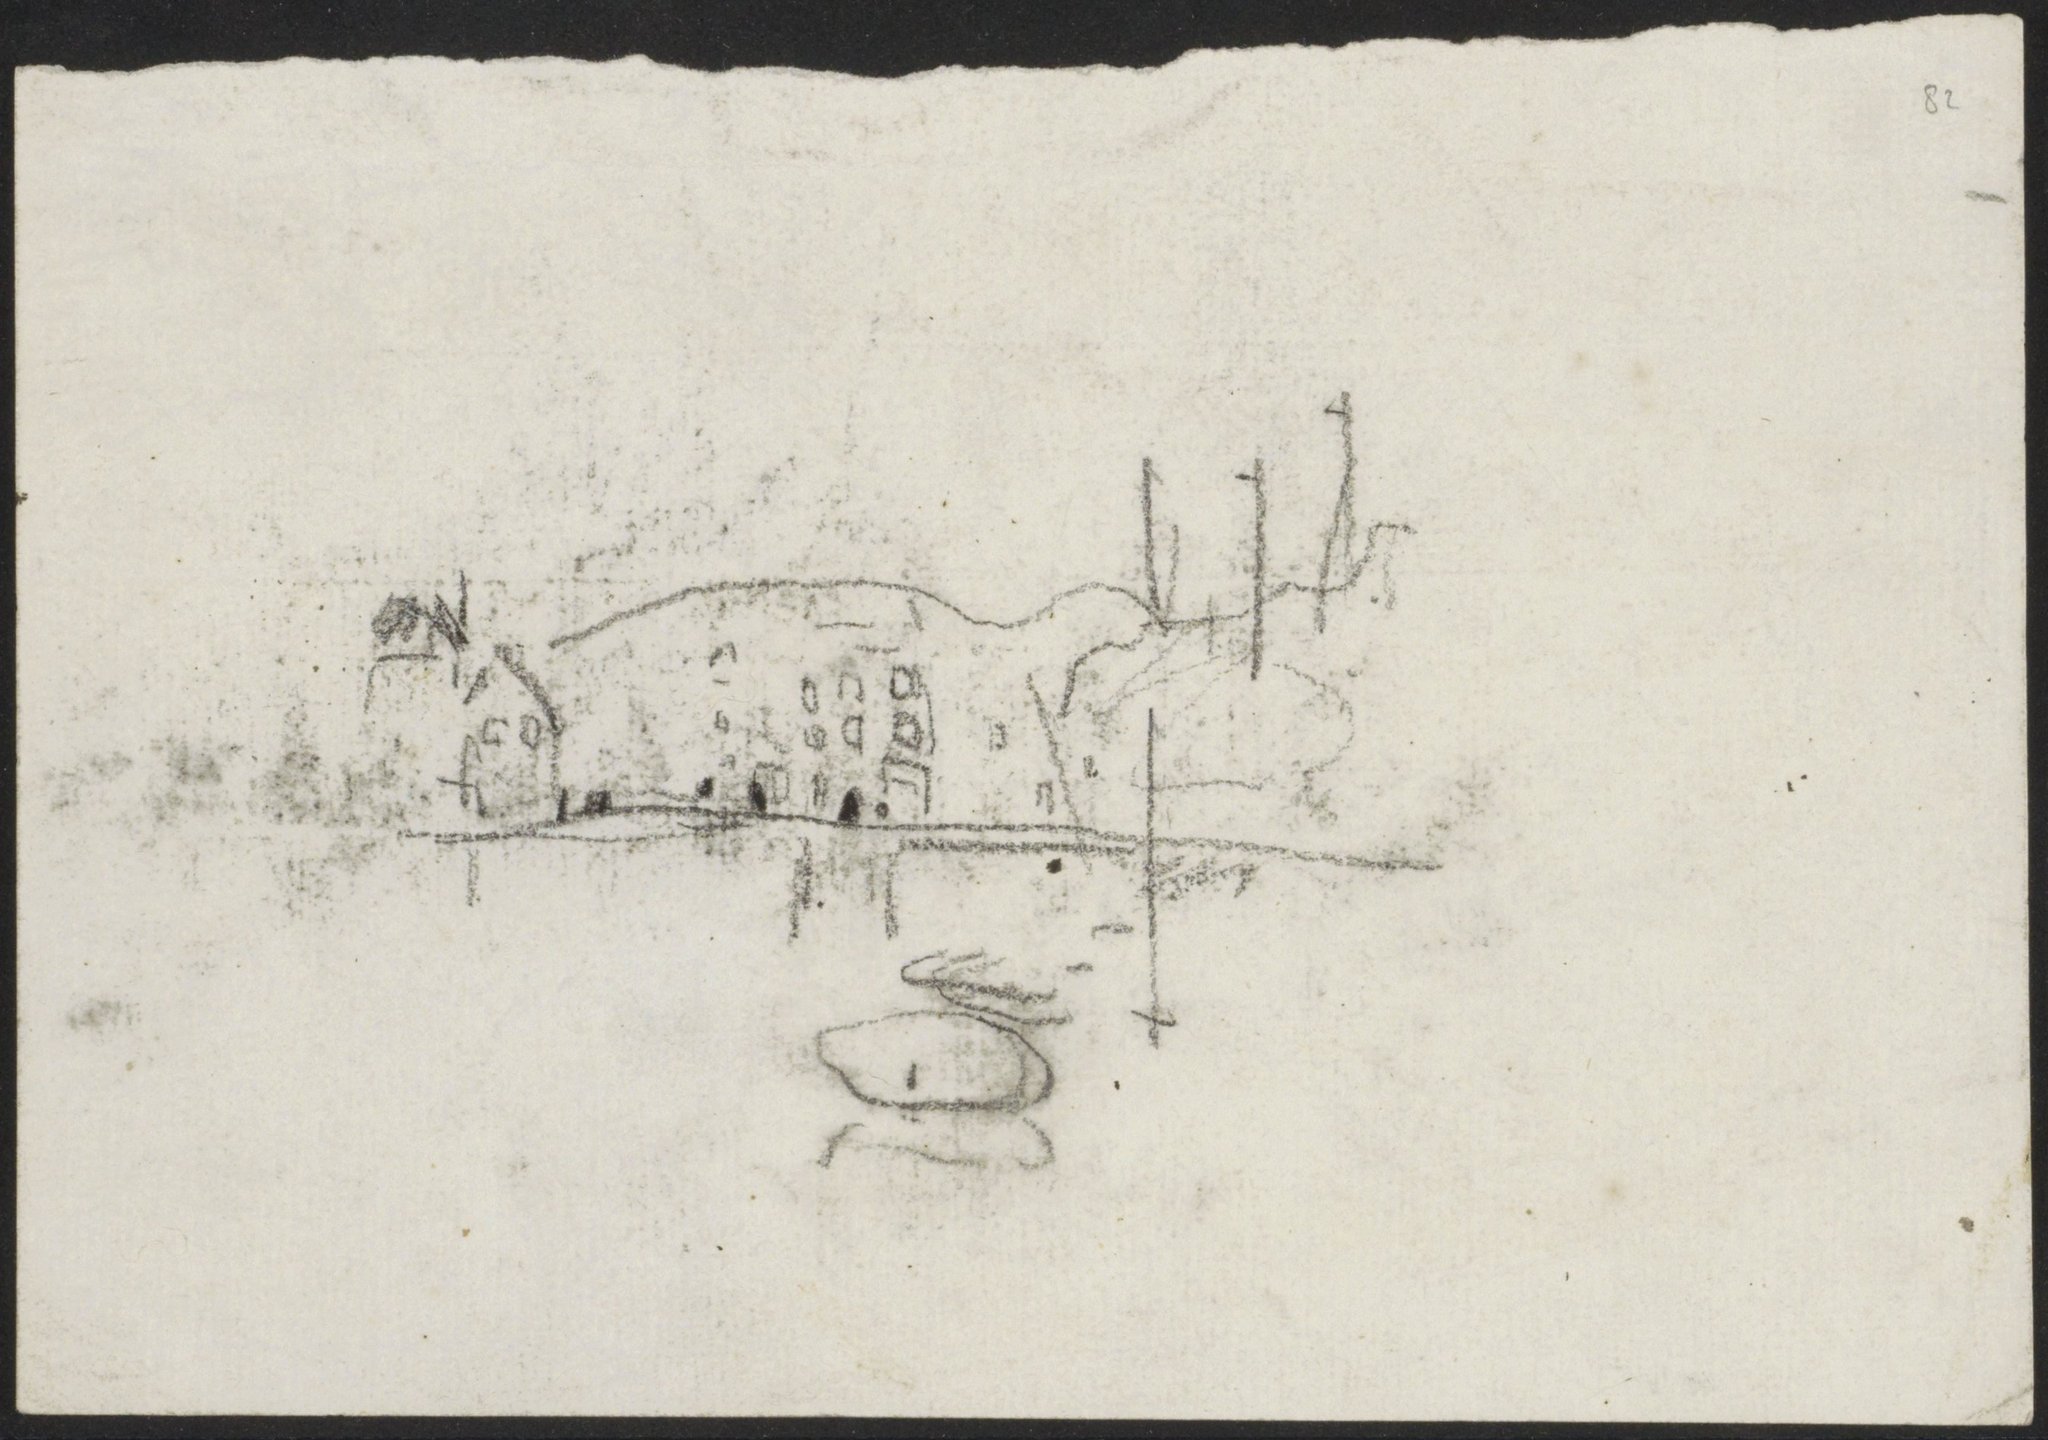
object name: sketchbook leaf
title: Gezicht in Amsterdam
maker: willem witsen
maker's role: draughtsman, painter, print maker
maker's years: 1860-1923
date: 1870-1923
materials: chalk, paper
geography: amsterdam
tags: city-view, and landscape with man-made constructions, amsterdam